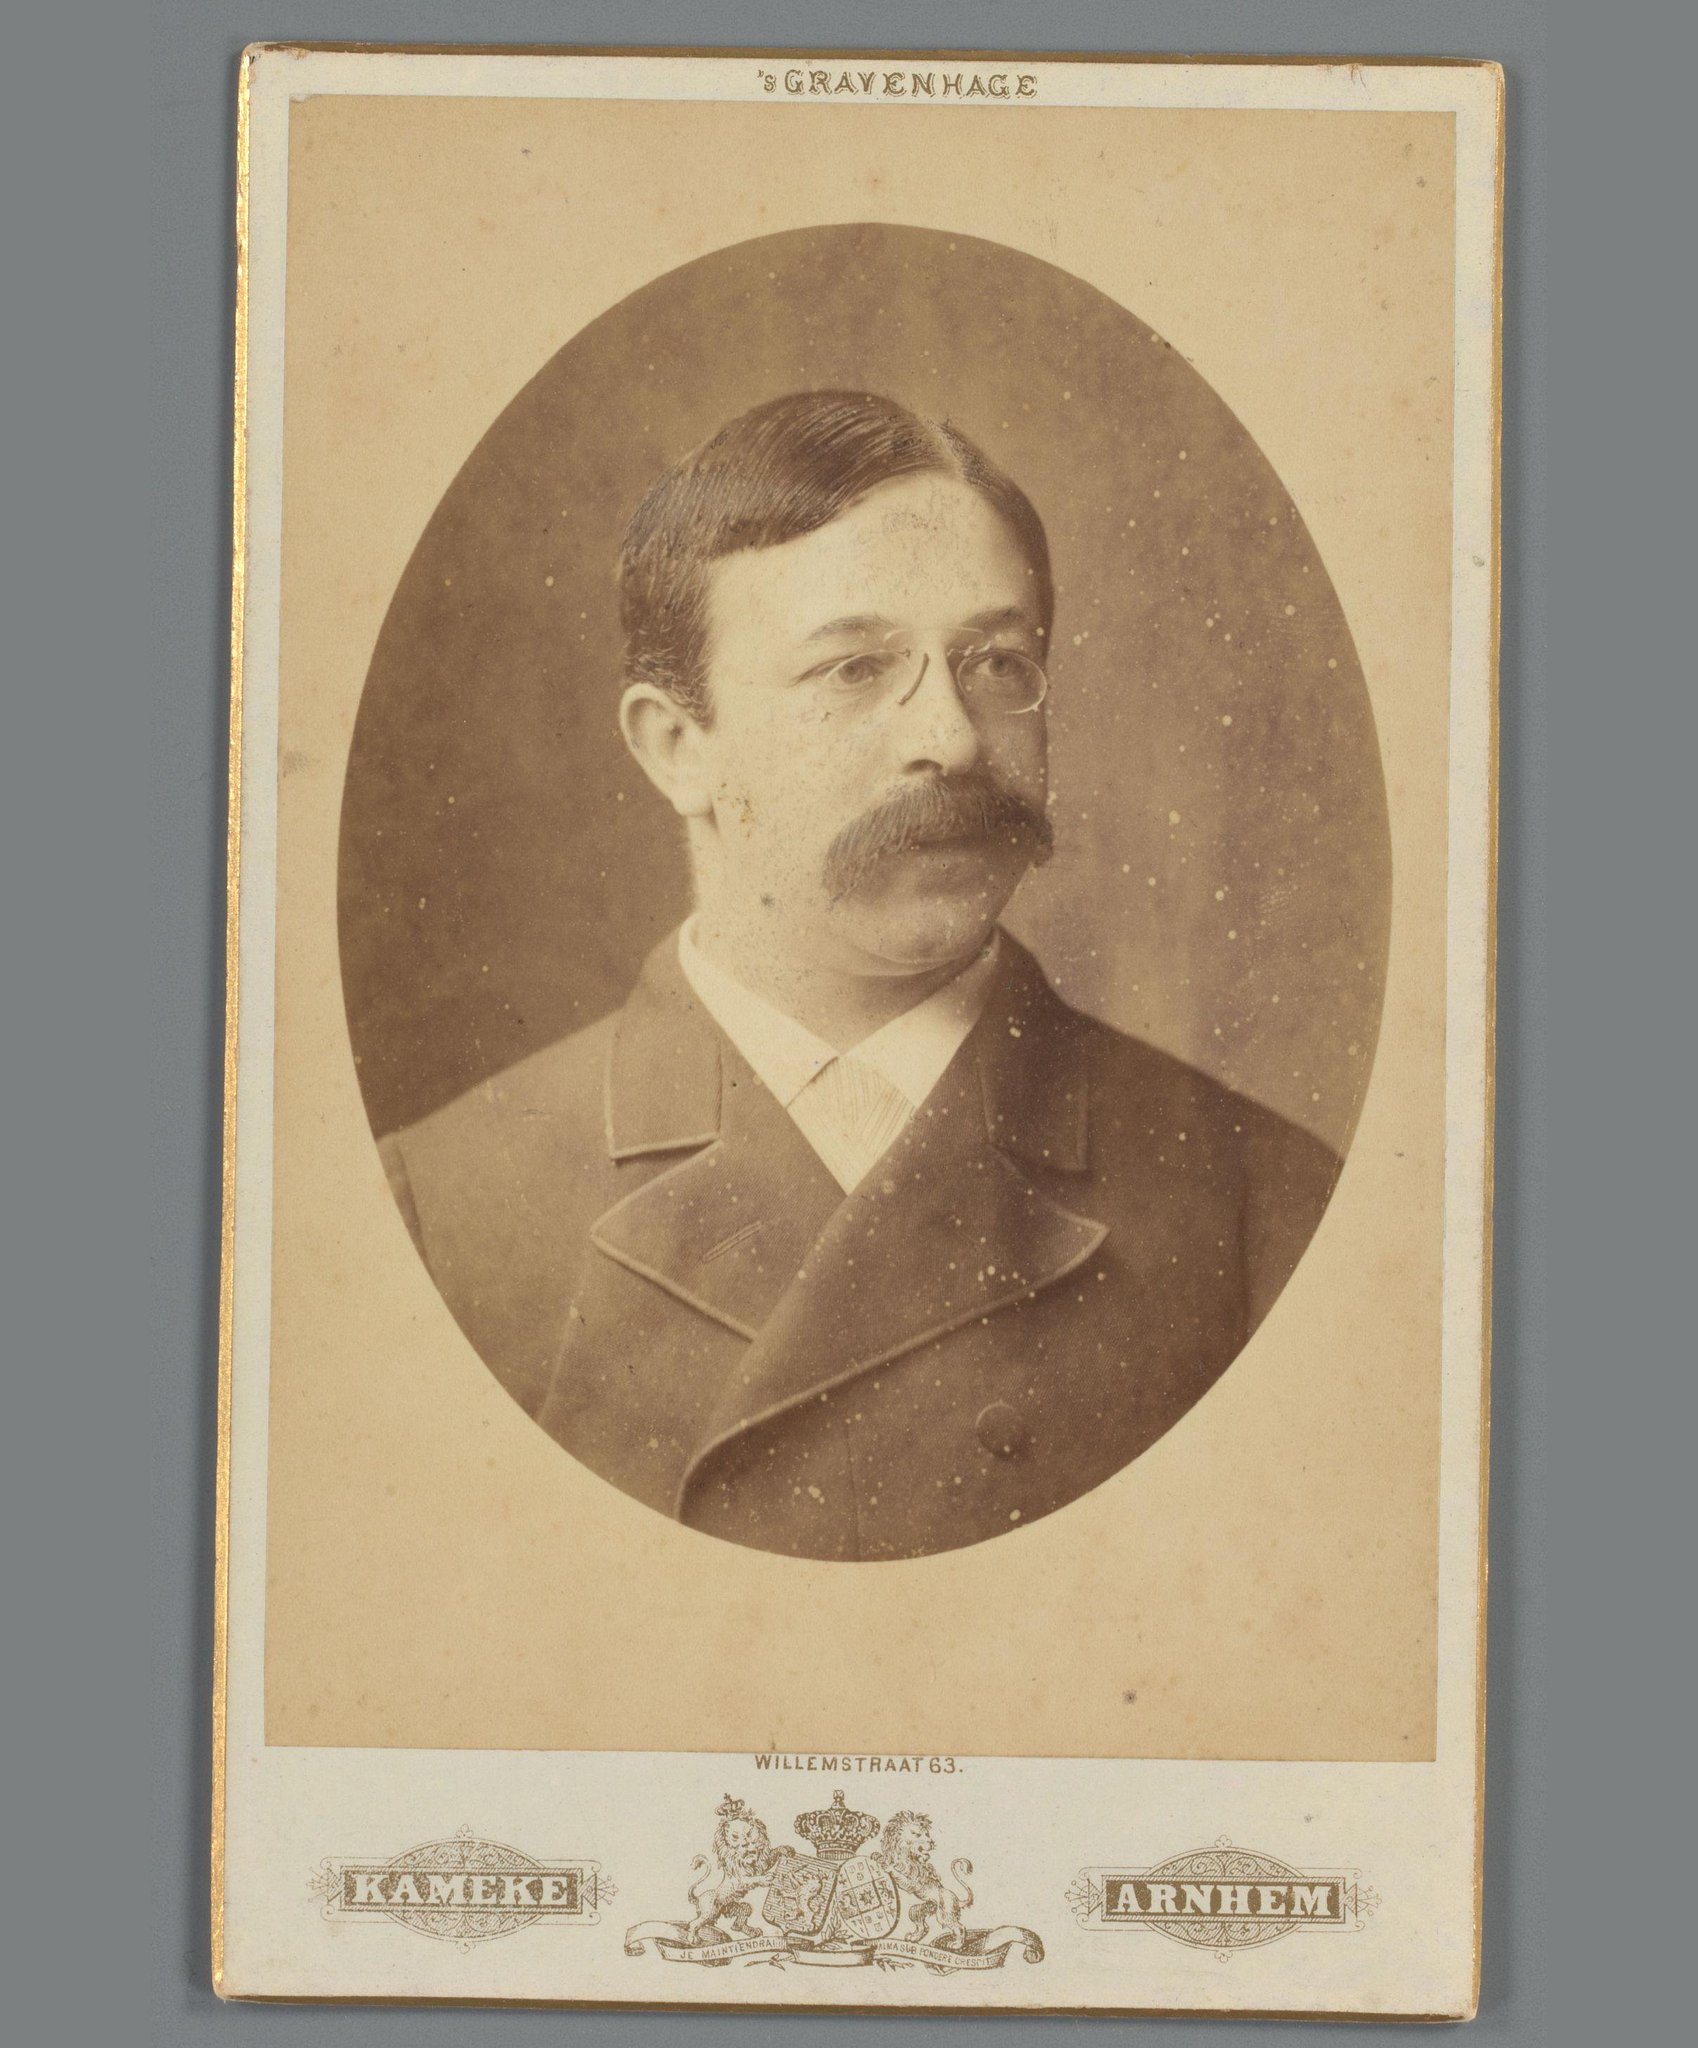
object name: cabinet photograph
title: Portret van een onbekende man met bril uit de familie en de kring van Eugene van Delden en Belle van Delden-Denninghof Stelling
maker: richard kameke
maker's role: fotograaf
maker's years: 1847-1898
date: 1884-1886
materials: cardboard, paper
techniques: albumen print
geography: the hague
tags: eyeglasses, spectacles, historical persons not known by name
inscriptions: inscription: ‘Kameke/ Kunstschilder/ Hofphotograph van H.H.M.M. den Koning en de Koningin/ der Nederlanden/ Arnhem/ 's Gravenhage Willemstraat, 63.’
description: Portret uit de kring van Eugene van Delden (Hartapoera, 1865 - Den Haag, 1954) en Belle van Delden-Denninghof Stelling (Batavia, 1870 - Den Haag, 1947).